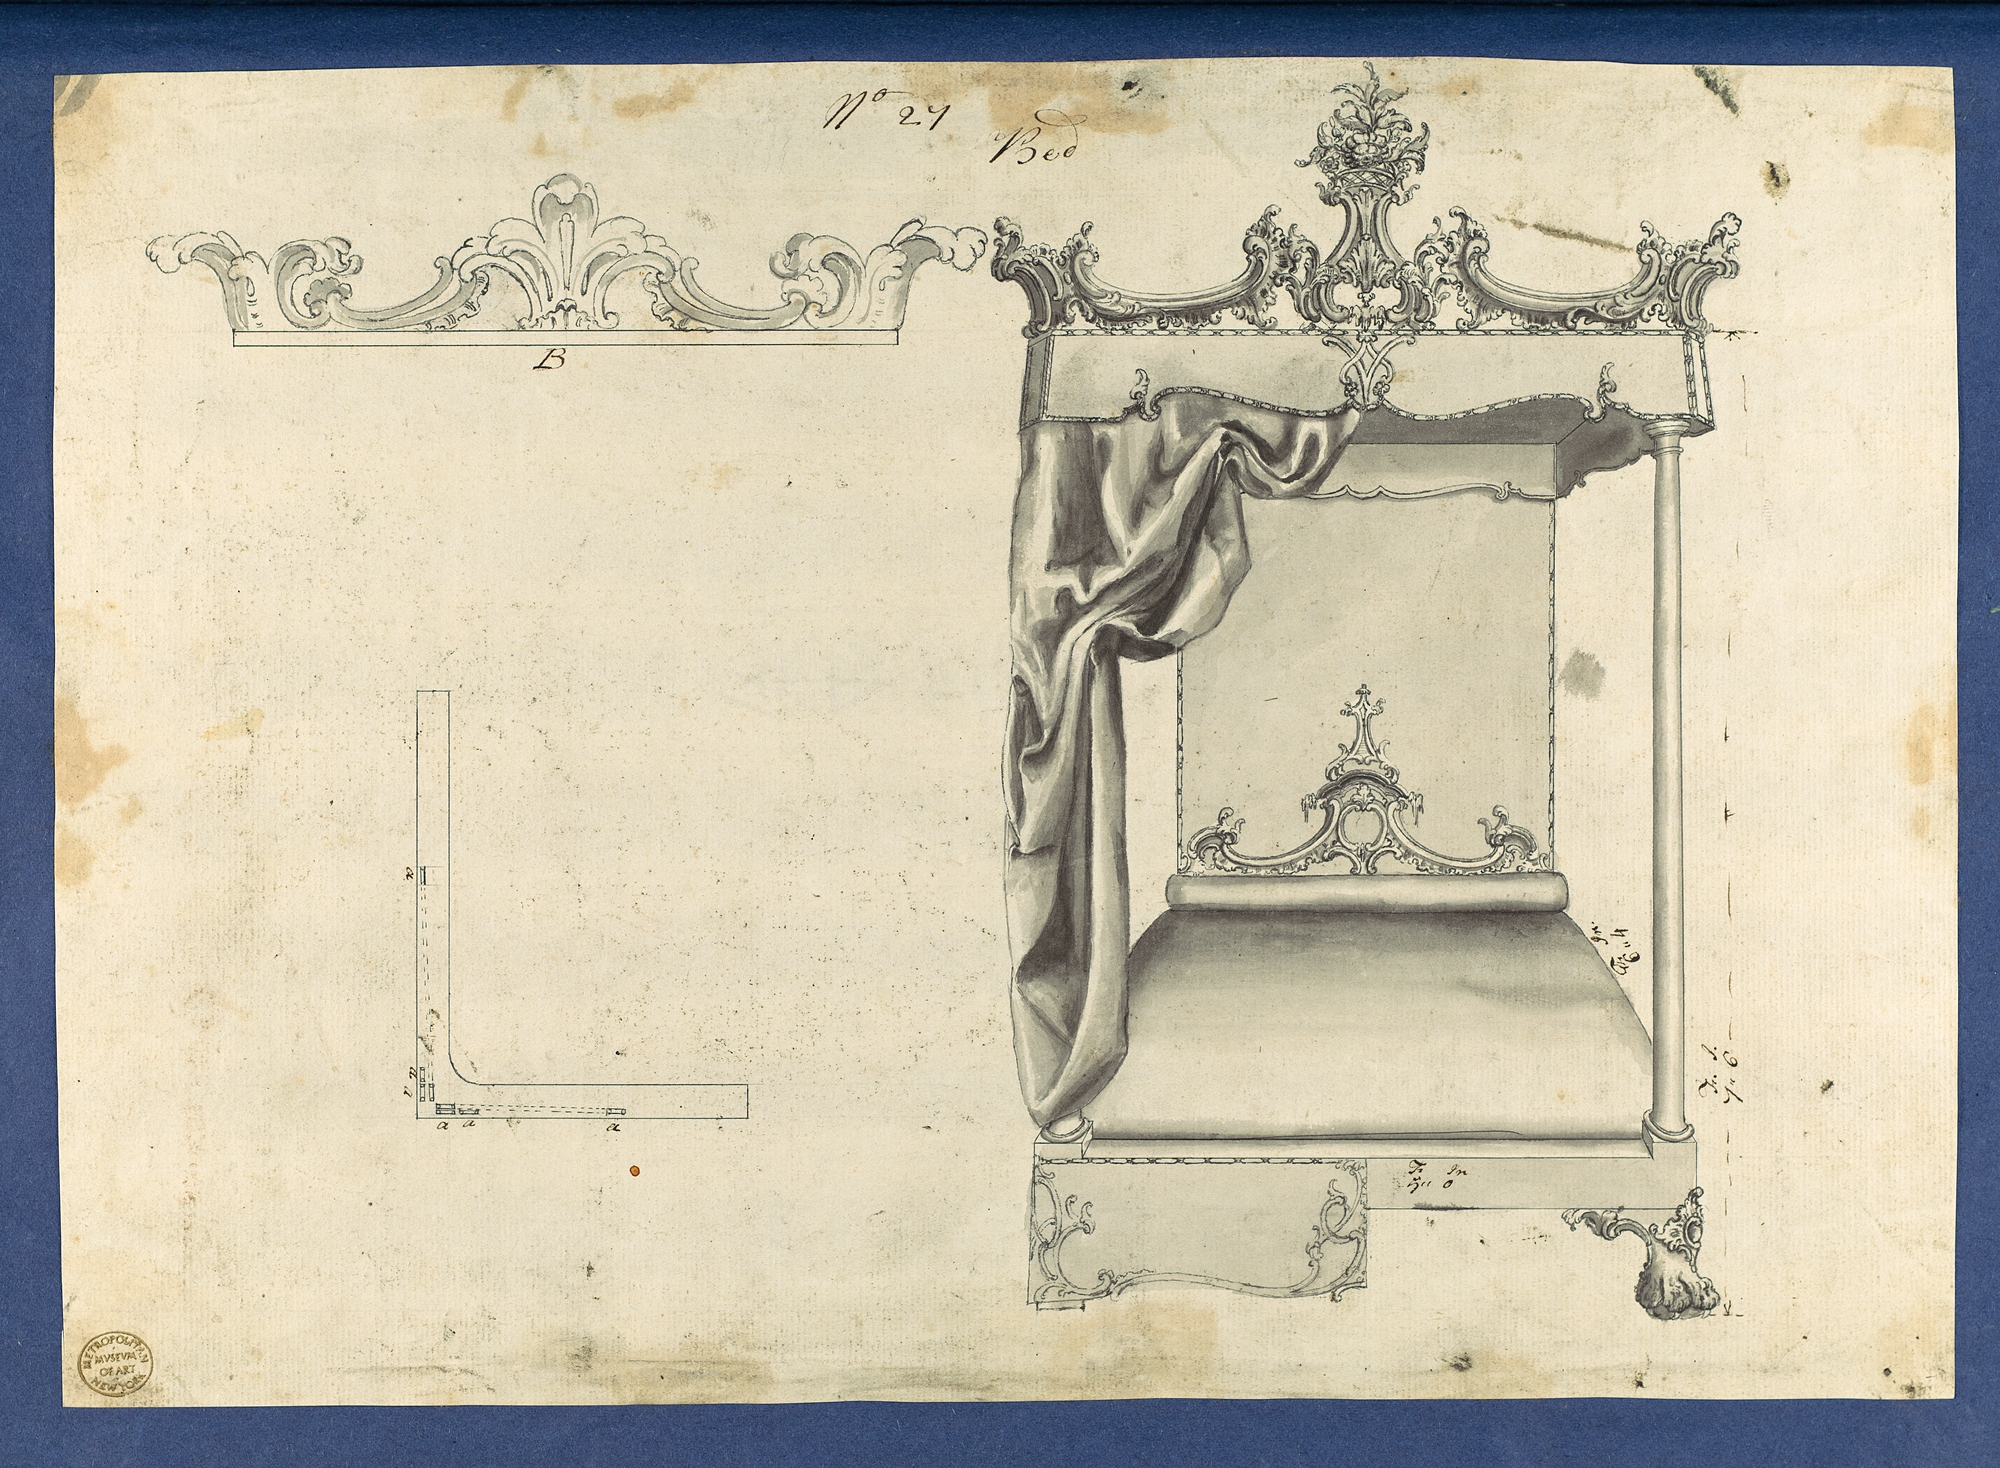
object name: drawing ornament architecture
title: Bed, in Chippendale Drawings, Vol. I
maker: thomas chippendale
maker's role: artist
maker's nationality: british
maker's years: 1718-1779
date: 1753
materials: ink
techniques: wash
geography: london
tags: beds